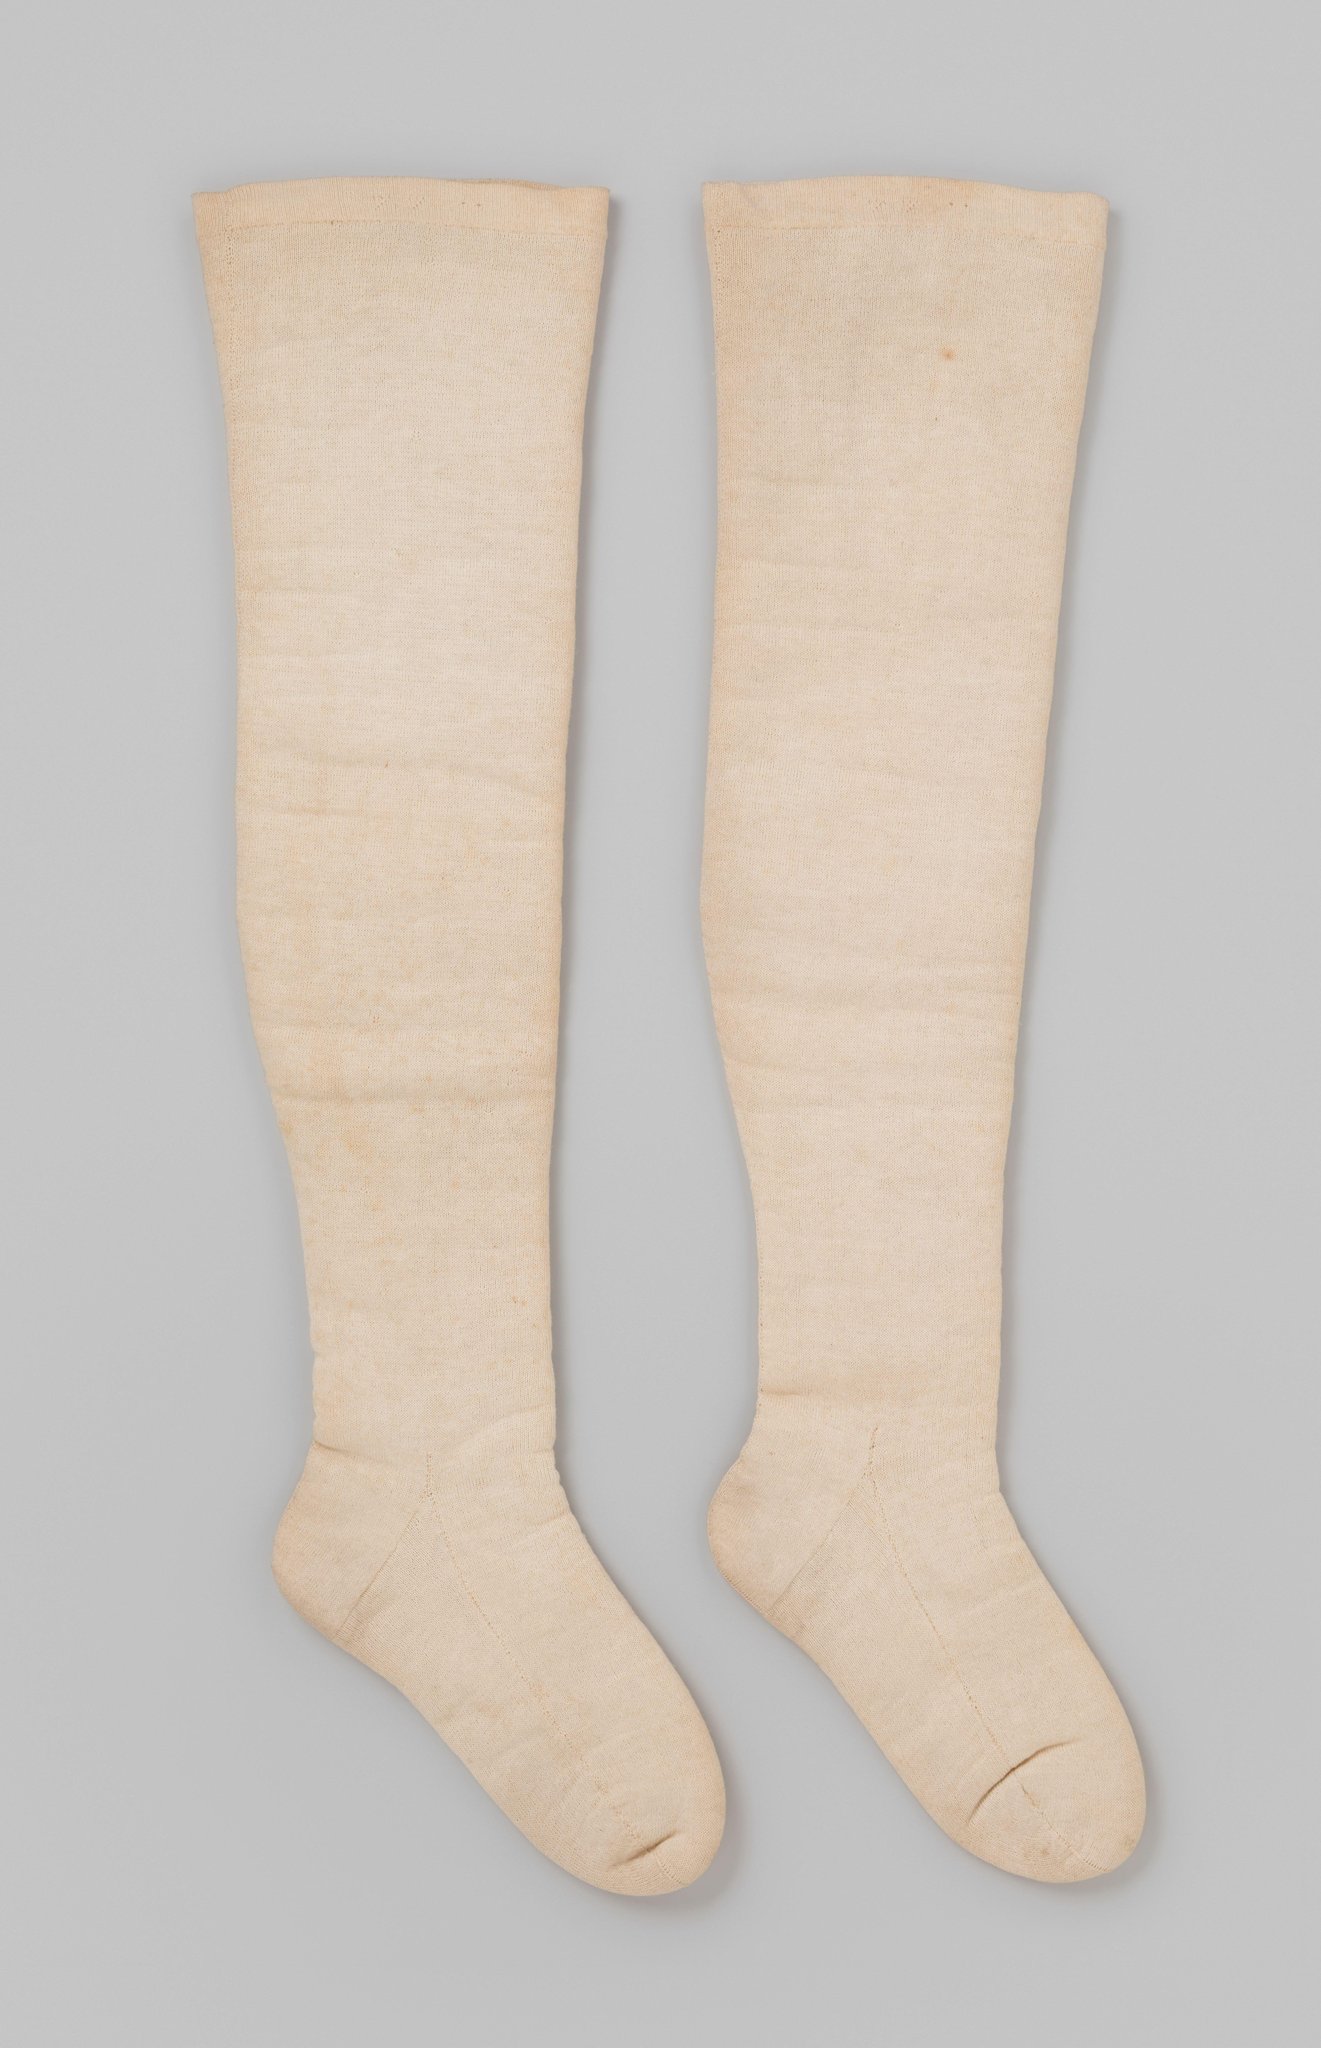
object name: clothing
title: Kousen van effen crèmekleurig katoen, gevoerd met ongesponnen wol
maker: Anonymous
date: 1780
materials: cotton, wool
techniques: knitting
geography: netherlands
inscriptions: initials: ‘YV (?)’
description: Kousen van effen crèmekleurig katoen, gevoerd met ongesponnen wol. Naad middenachter. Ingebreide initialen op de bovenrand: YV (?).